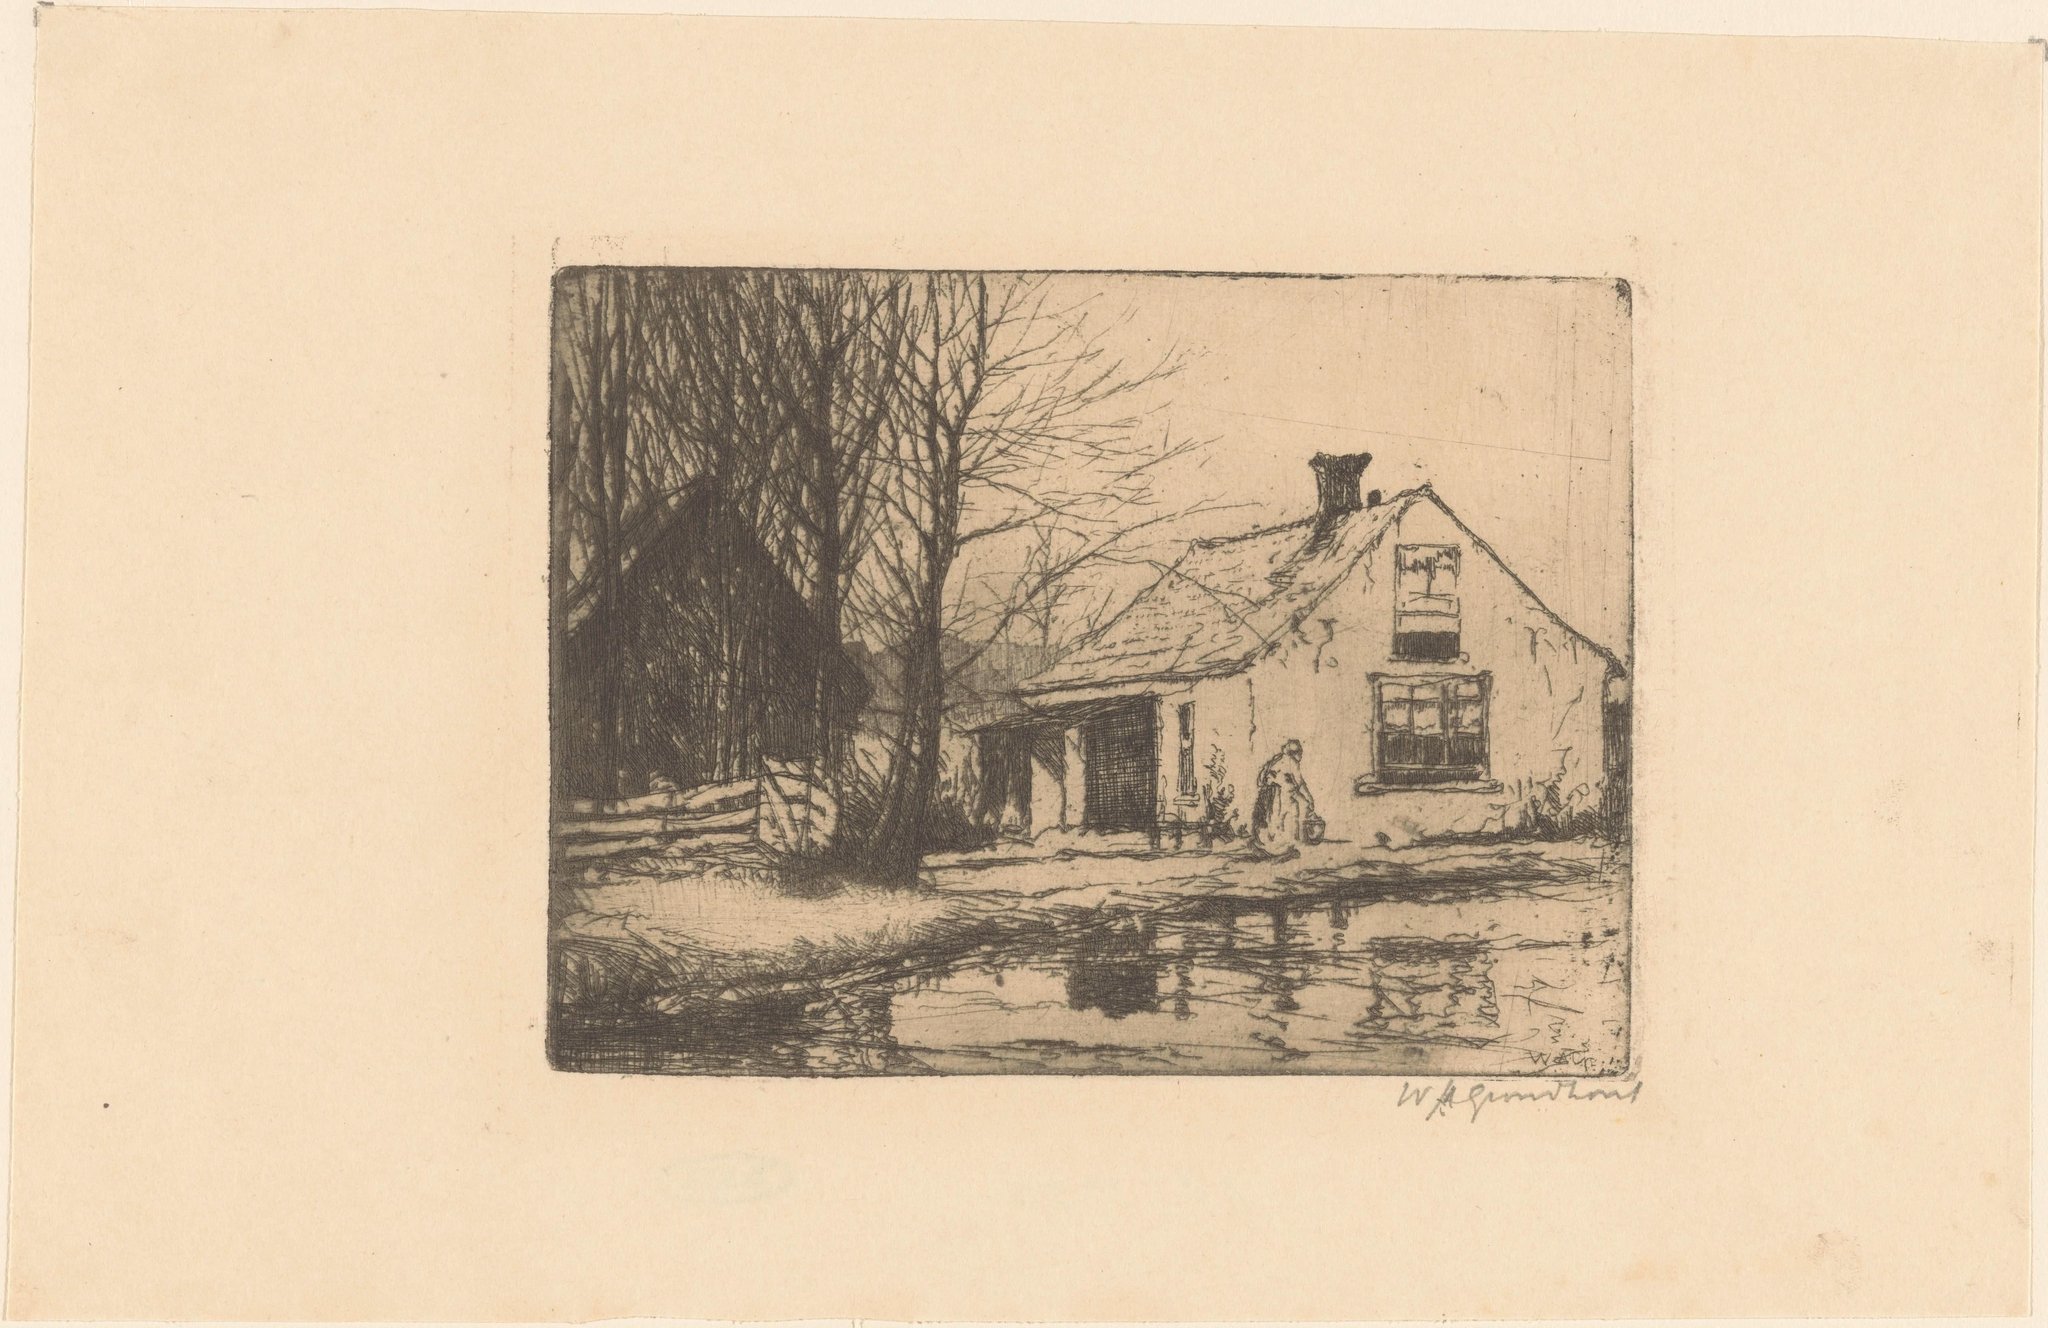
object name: print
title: Boerderij aan het water in Voorburg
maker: willem adrianus grondhout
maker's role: draughtsman, painter, print maker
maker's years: 1878-1934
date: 1888-1934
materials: paper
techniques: etching, intaglio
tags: farm or solitary house in landscape, voorburg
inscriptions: collector's mark: Lugt 2228